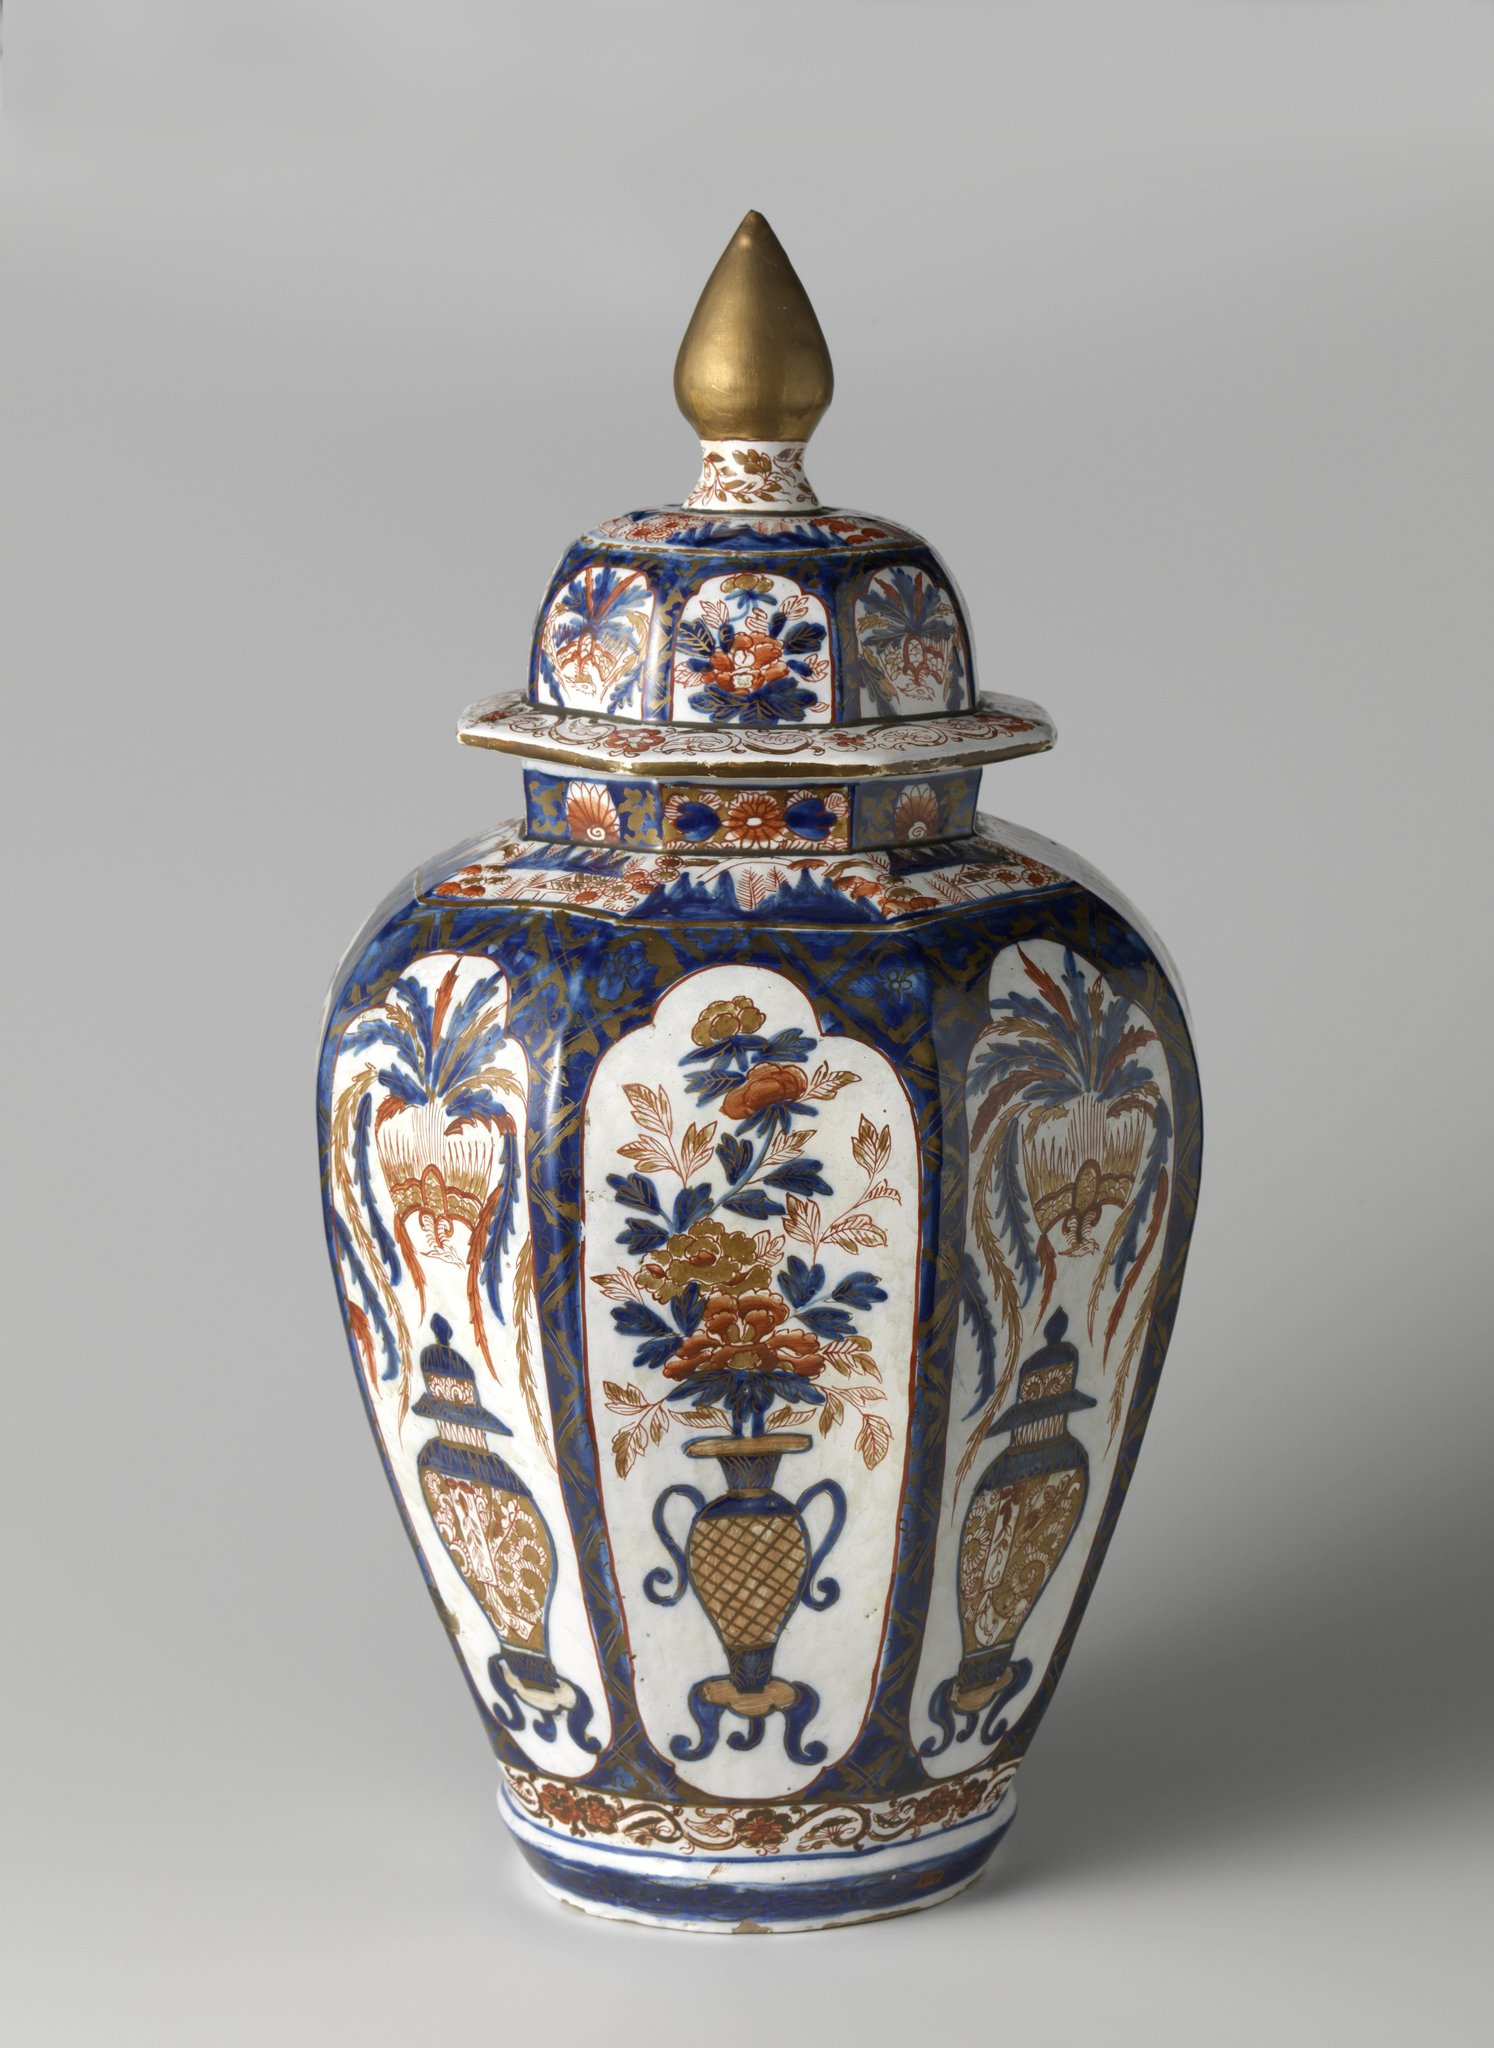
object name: lid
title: Deksel van een pot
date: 1820-1850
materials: earthenware, glaze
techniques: painted, polychromy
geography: delft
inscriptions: collector's mark: ‘collection J.F. Loudon’, mark: ‘IVP & C’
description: Deksel van veelkleurig beschilderde faïence. De pot is achtkantig en op de acht kanten zijn acht vakken geschilderd. In vier vakken is een vaas met twee s-vormige handvatten, staand op een driepotig voetstuk en gevuld met bloemen geschilderd, in de andere vier vakken een pot met deksel op een driepotig voetstuk waarboven een feniks. De pot is gemerkt en is onderdeel van een stel.